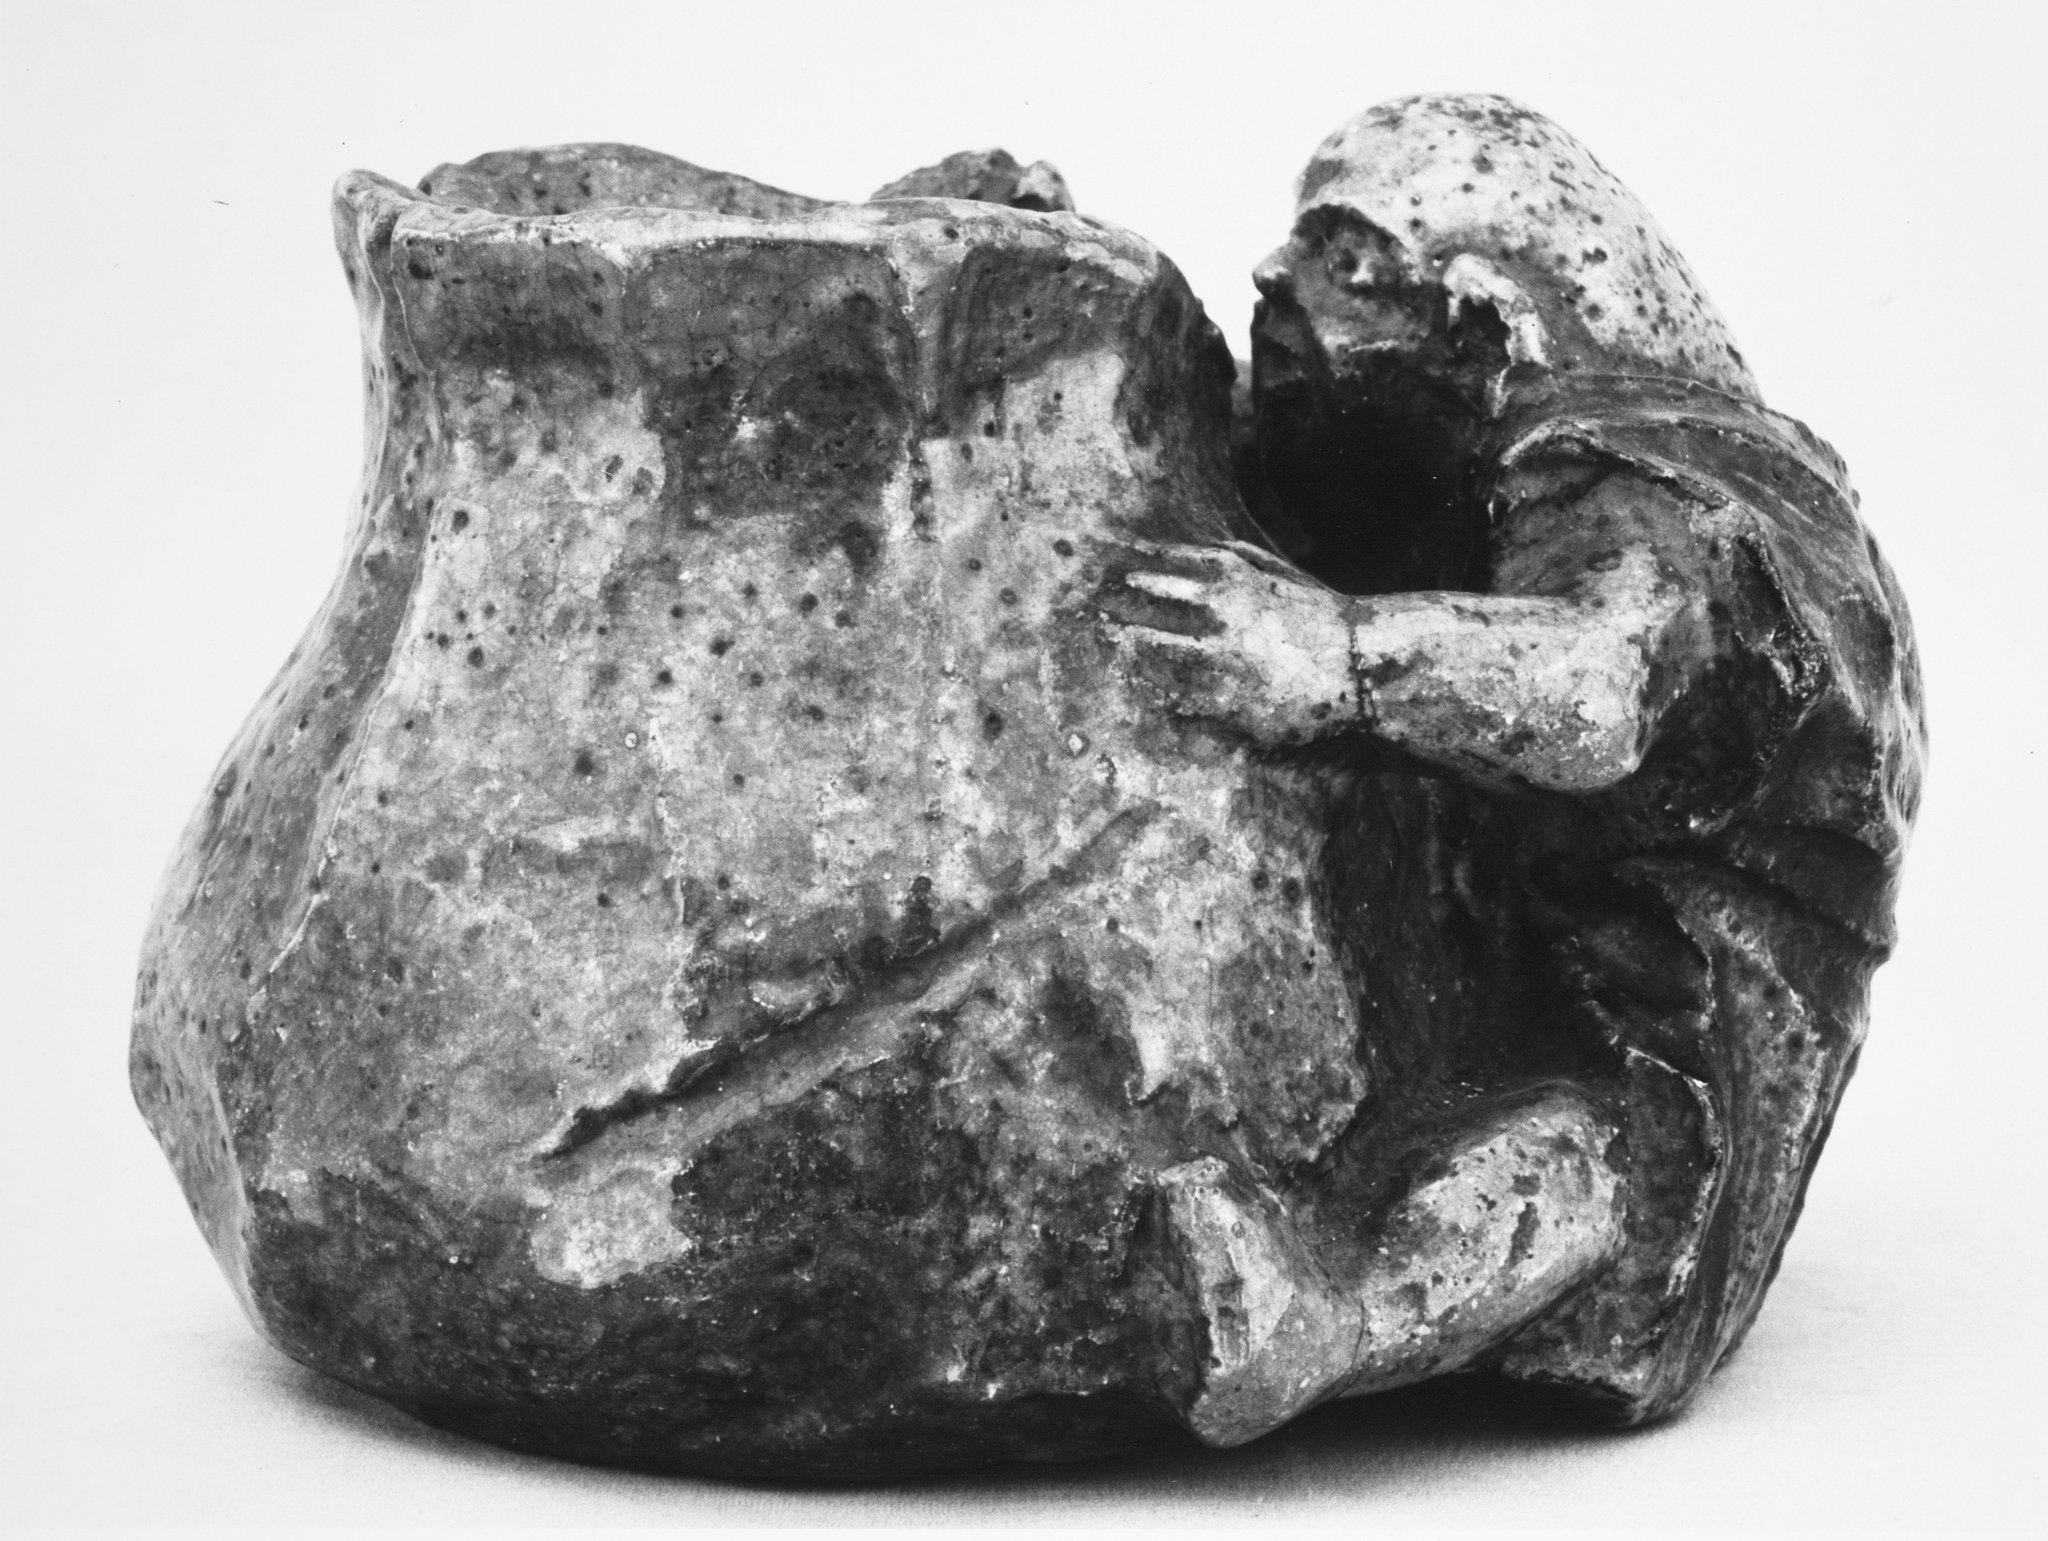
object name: vase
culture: japanese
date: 1801-1900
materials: glaze